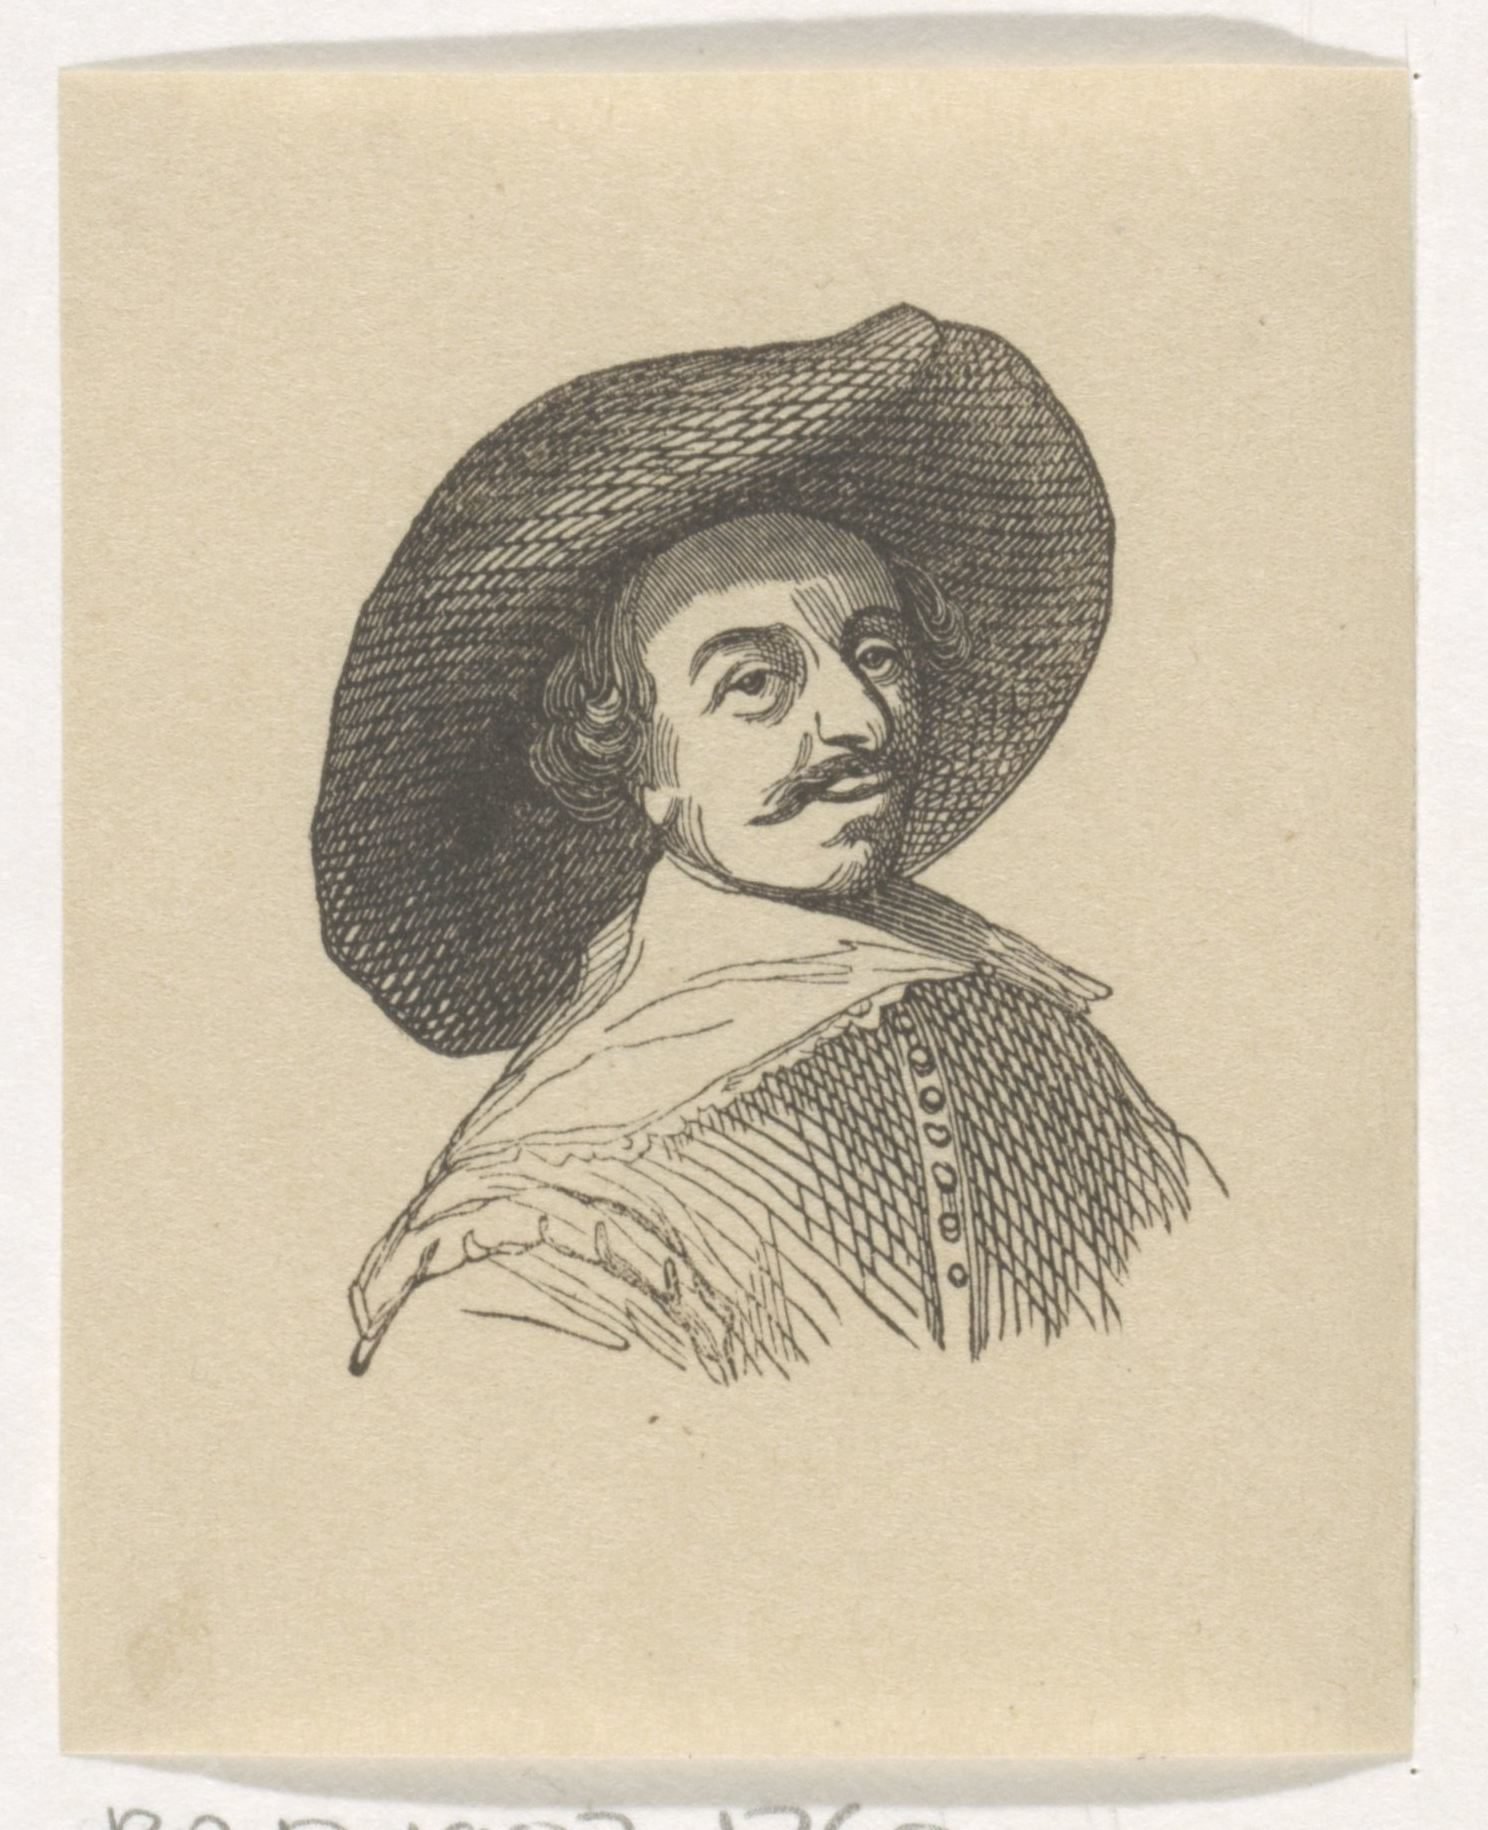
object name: book illustration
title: Portret van Jan van der Heyden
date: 1842-1843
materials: paper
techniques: engraving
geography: amsterdam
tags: amsterdam, painter, print maker, draughtsman, jan van der heyden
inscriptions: collector's mark: Lugt 2228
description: Prent uit: Immerzeel, Johannes. De levens en werken der Hollandsche en Vlaamsche kunstschilders, beeldhouwers, graveurs en bouwmeesters : van het begin der vijftiende eeuw tot heden. Amsterdam: J.C. van Kesteren, 1842-1843.